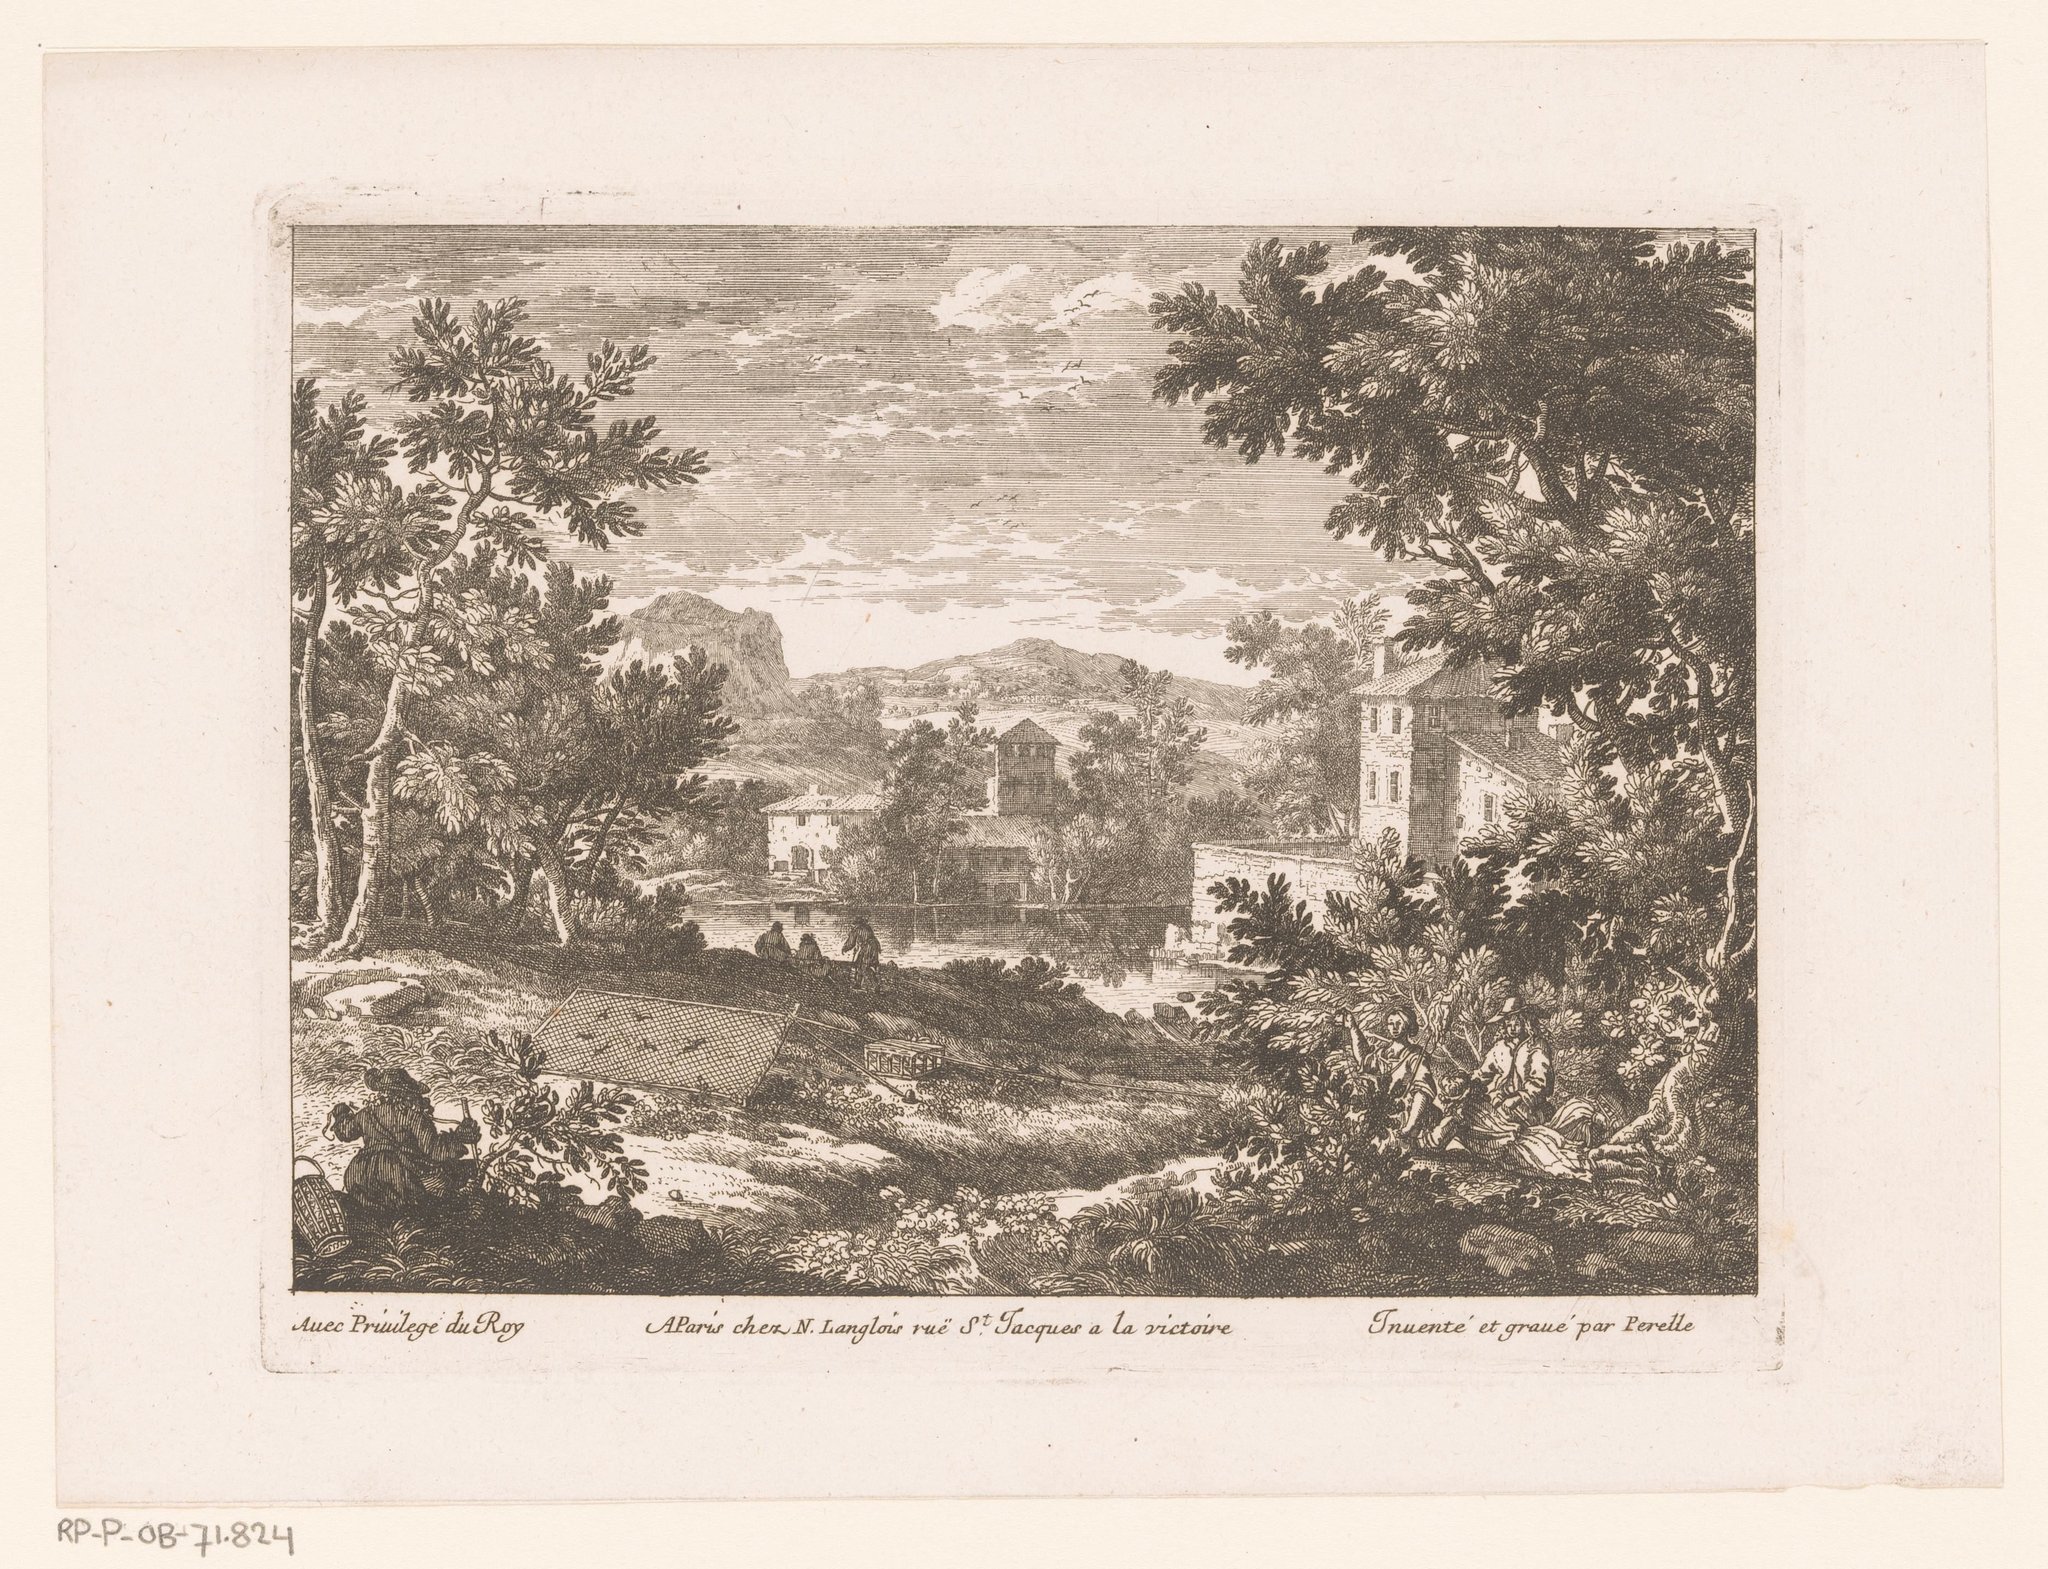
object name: print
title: Landschap met vogelvangers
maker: lodewijk xiv (koning van frankrijk)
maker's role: koning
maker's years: 1638-1715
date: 1650-1695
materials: paper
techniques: engraving, etching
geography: france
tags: bird hunting, landscapes (+ landscape with figures, staffage)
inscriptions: collector's mark: Lugt 240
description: Prenten met het signatuur 'Perelle' kunnen zowel door vader Gabriel als door zonen Nicolas en Adam gemaakt zijn.